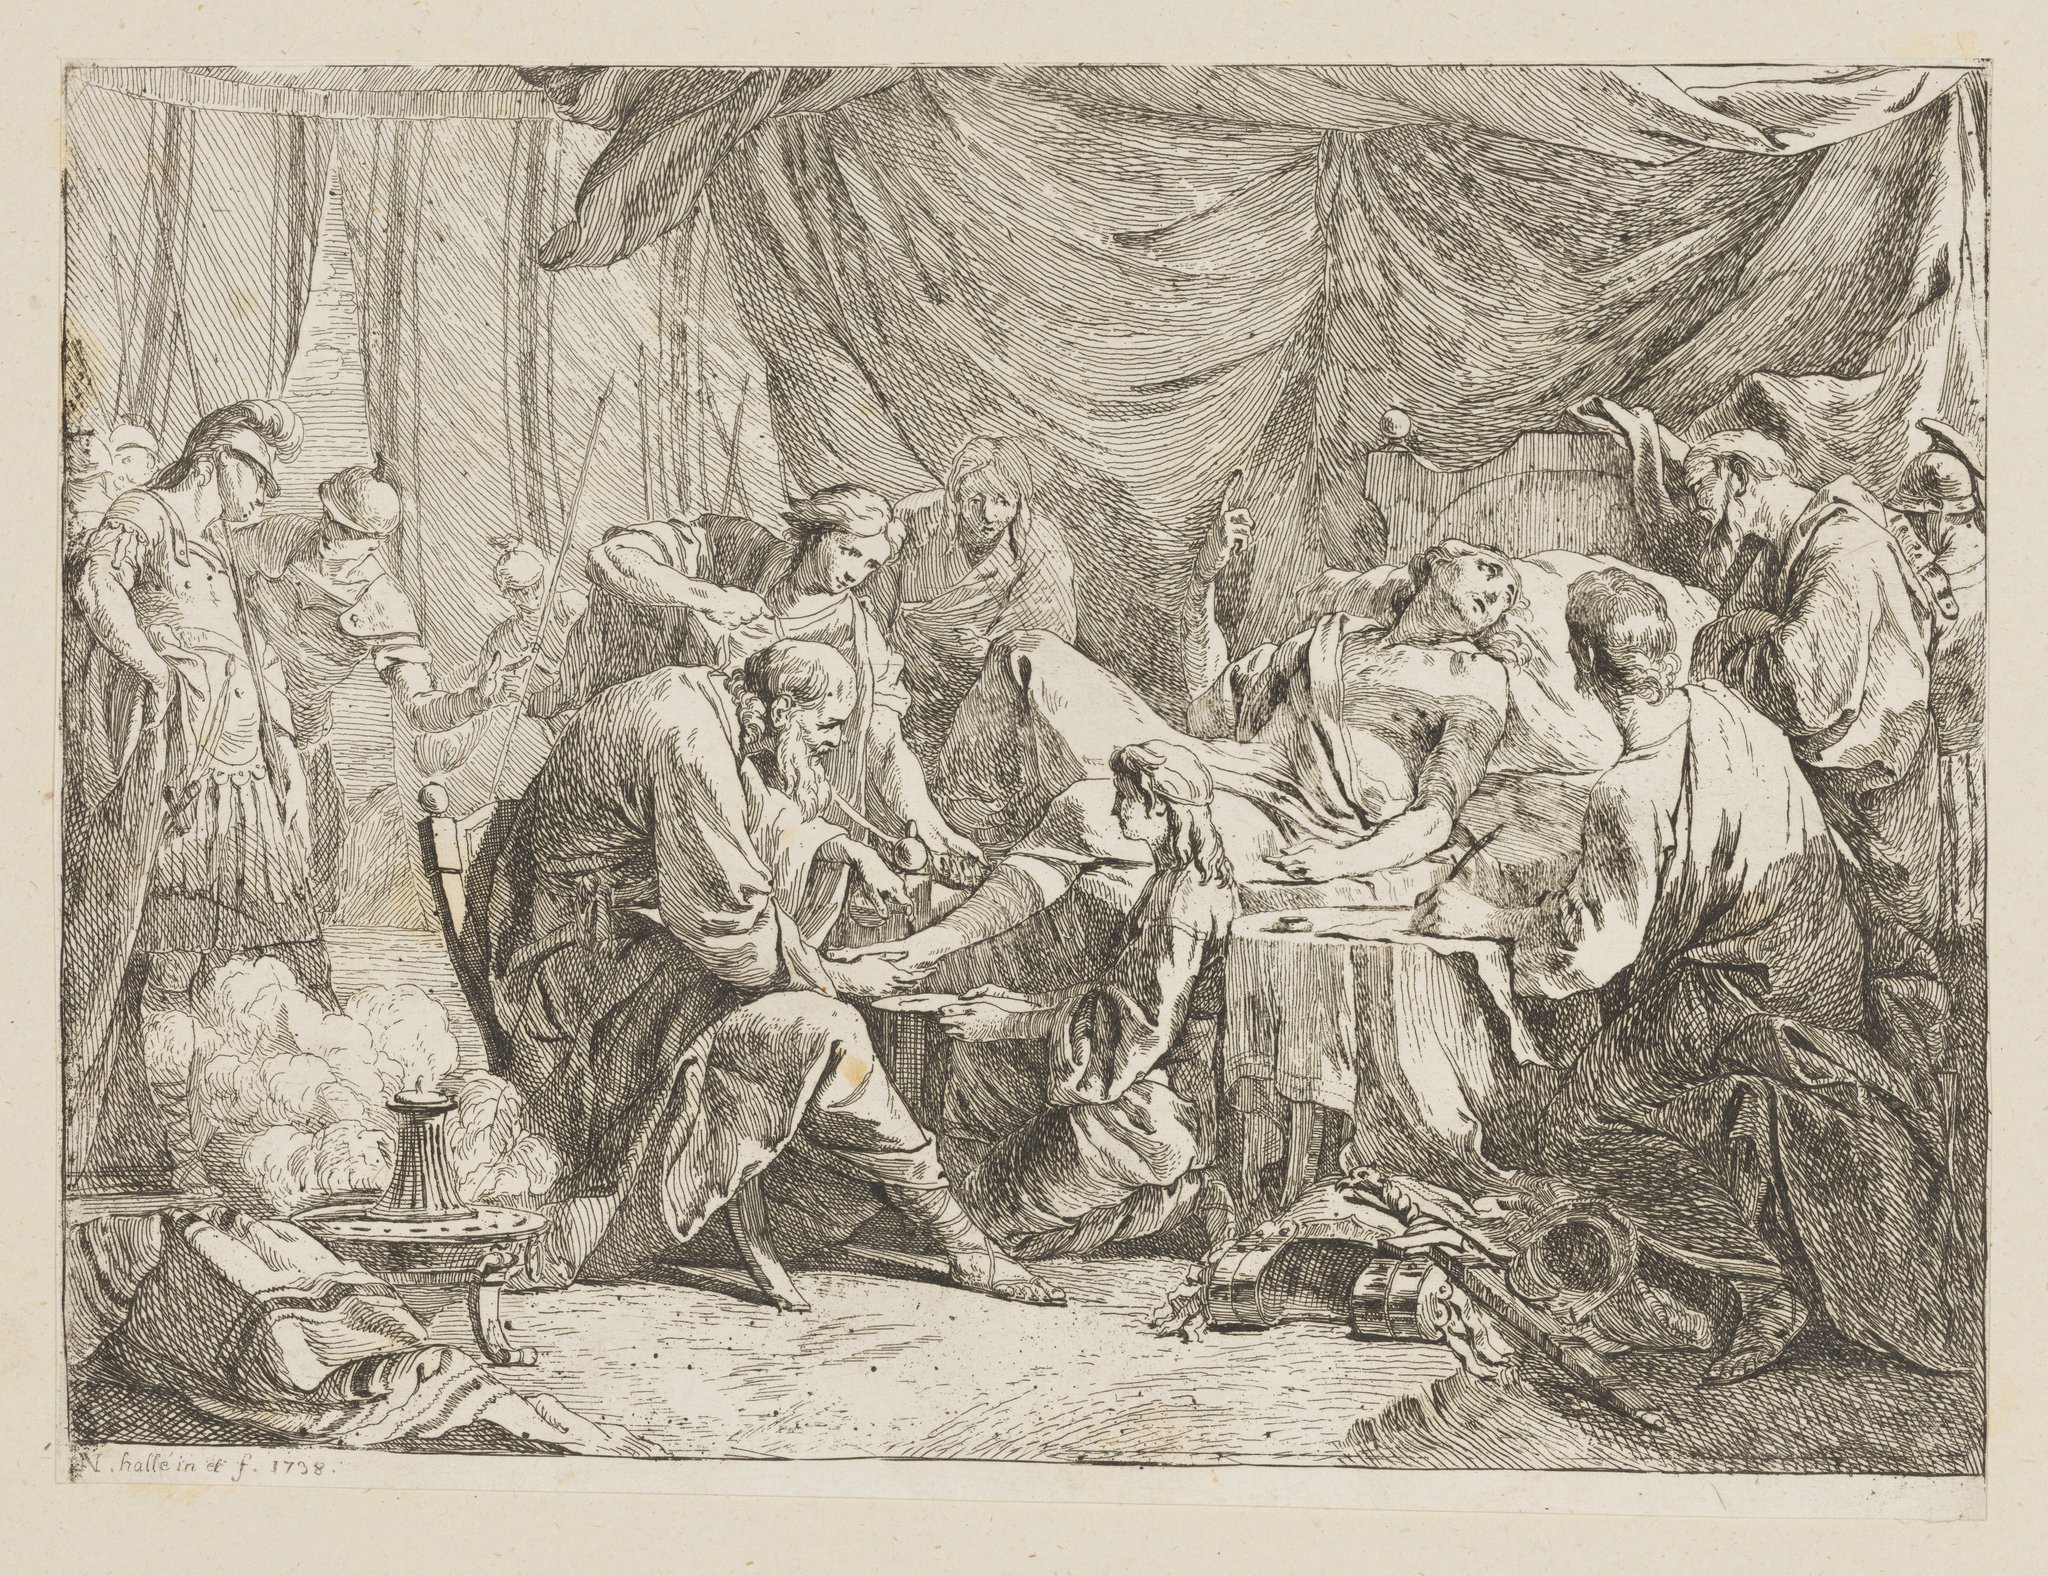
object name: print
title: Death of Antiochus After His Fall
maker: noël hallé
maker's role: artist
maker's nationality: french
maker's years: 1711-1781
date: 1738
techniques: etching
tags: soldiers,men,women,death